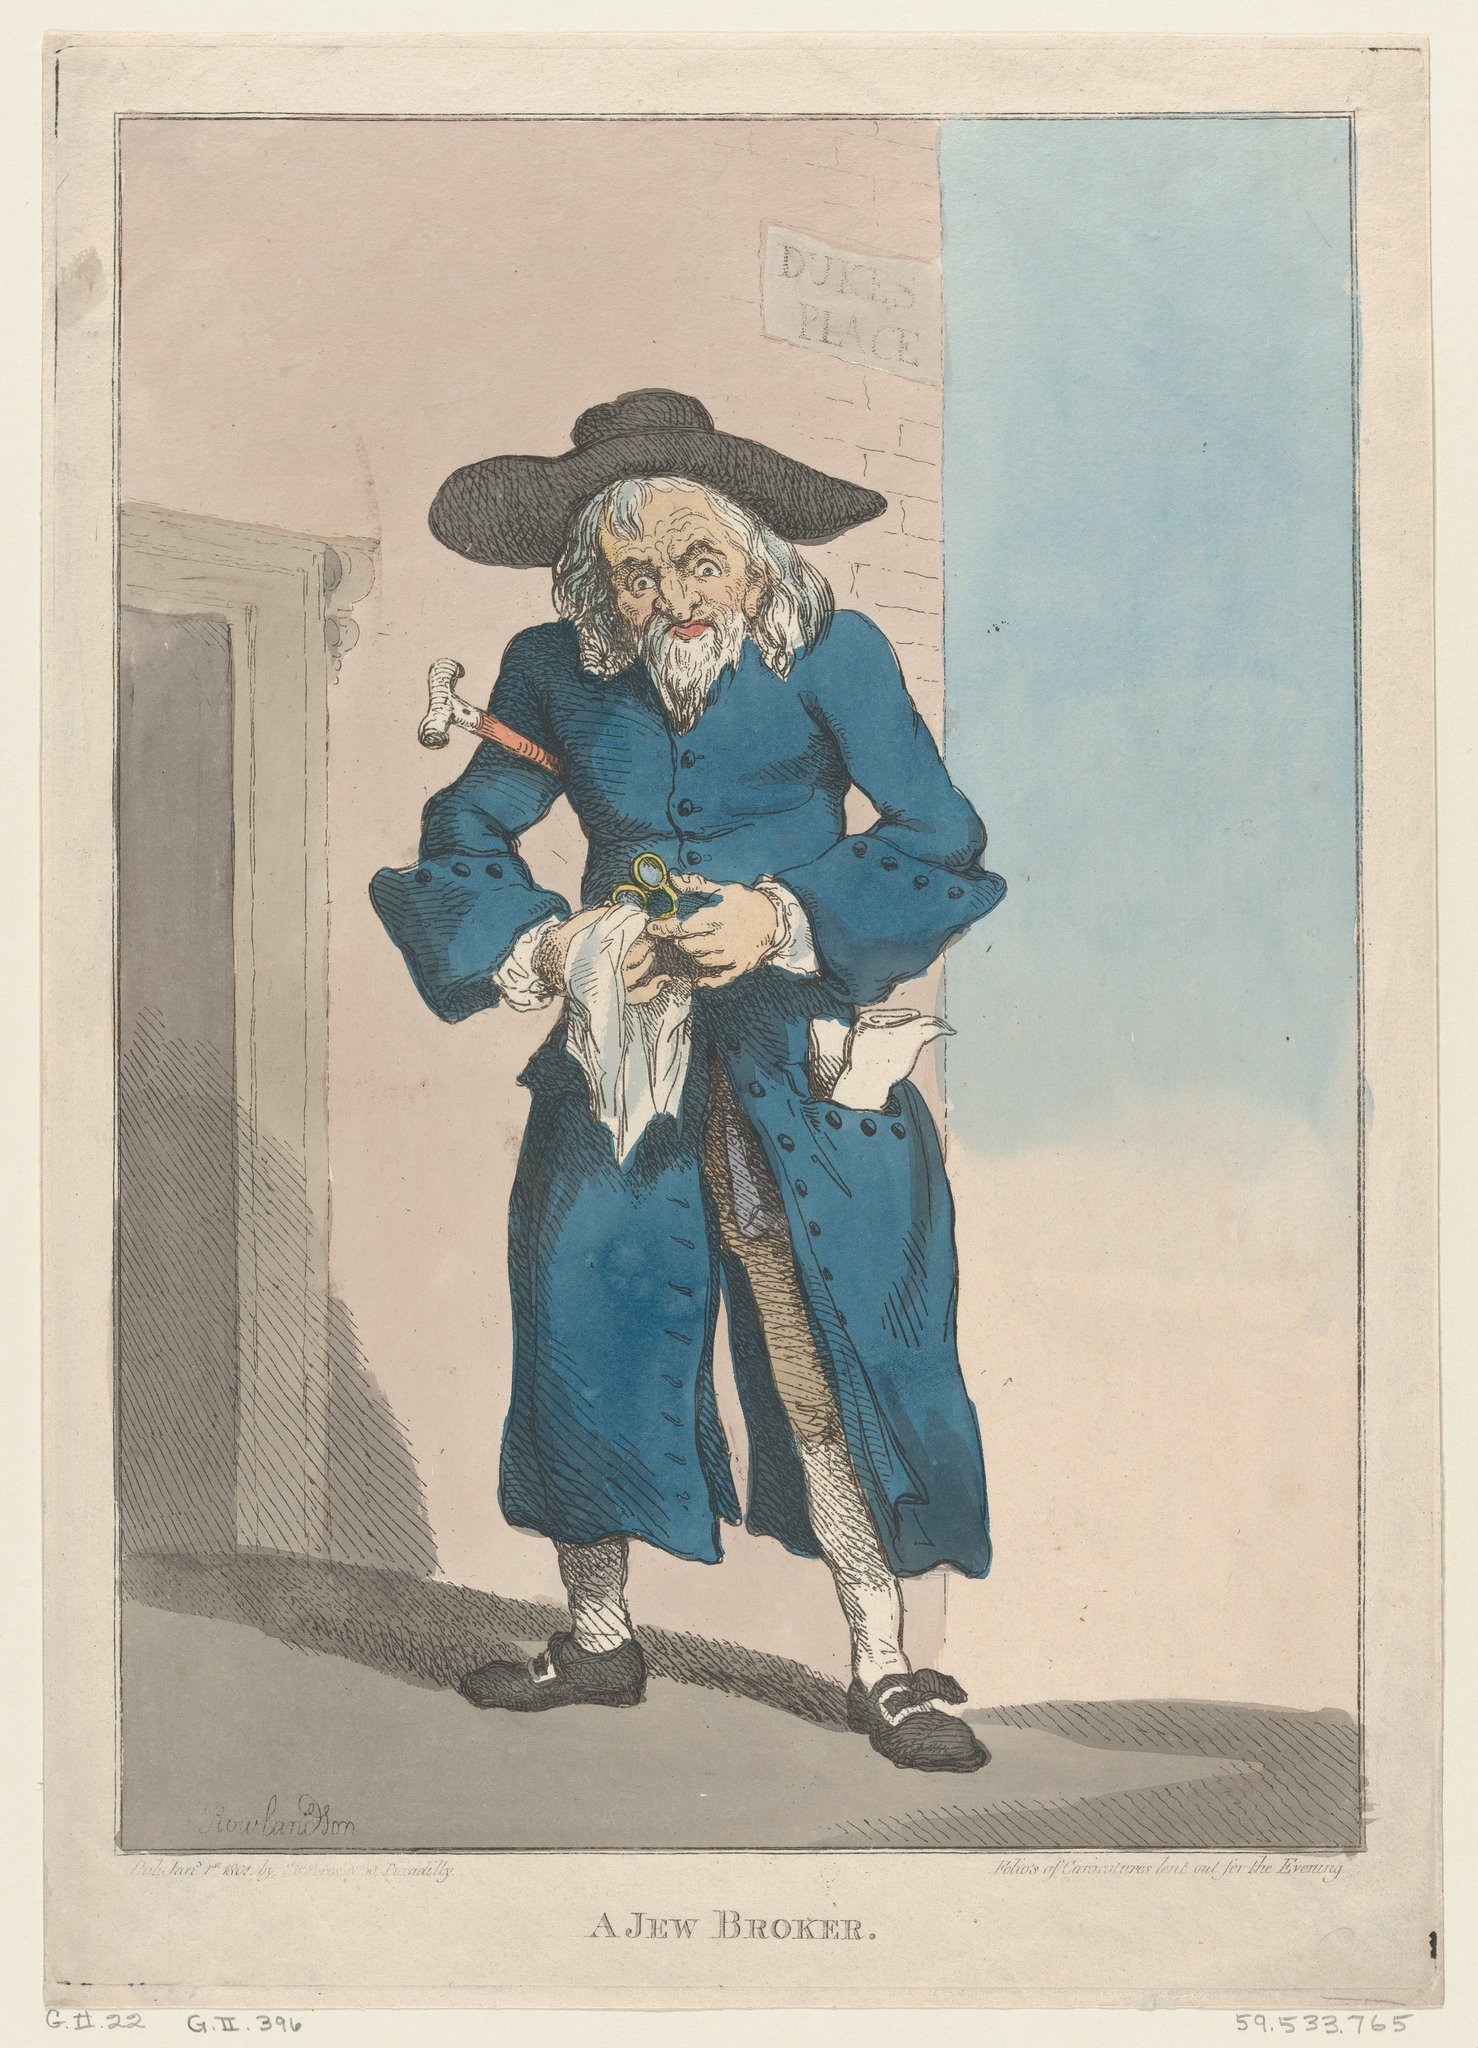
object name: print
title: A Jew Broker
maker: thomas rowlandson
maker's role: artist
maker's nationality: british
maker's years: 1757-1827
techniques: etching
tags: satire,men